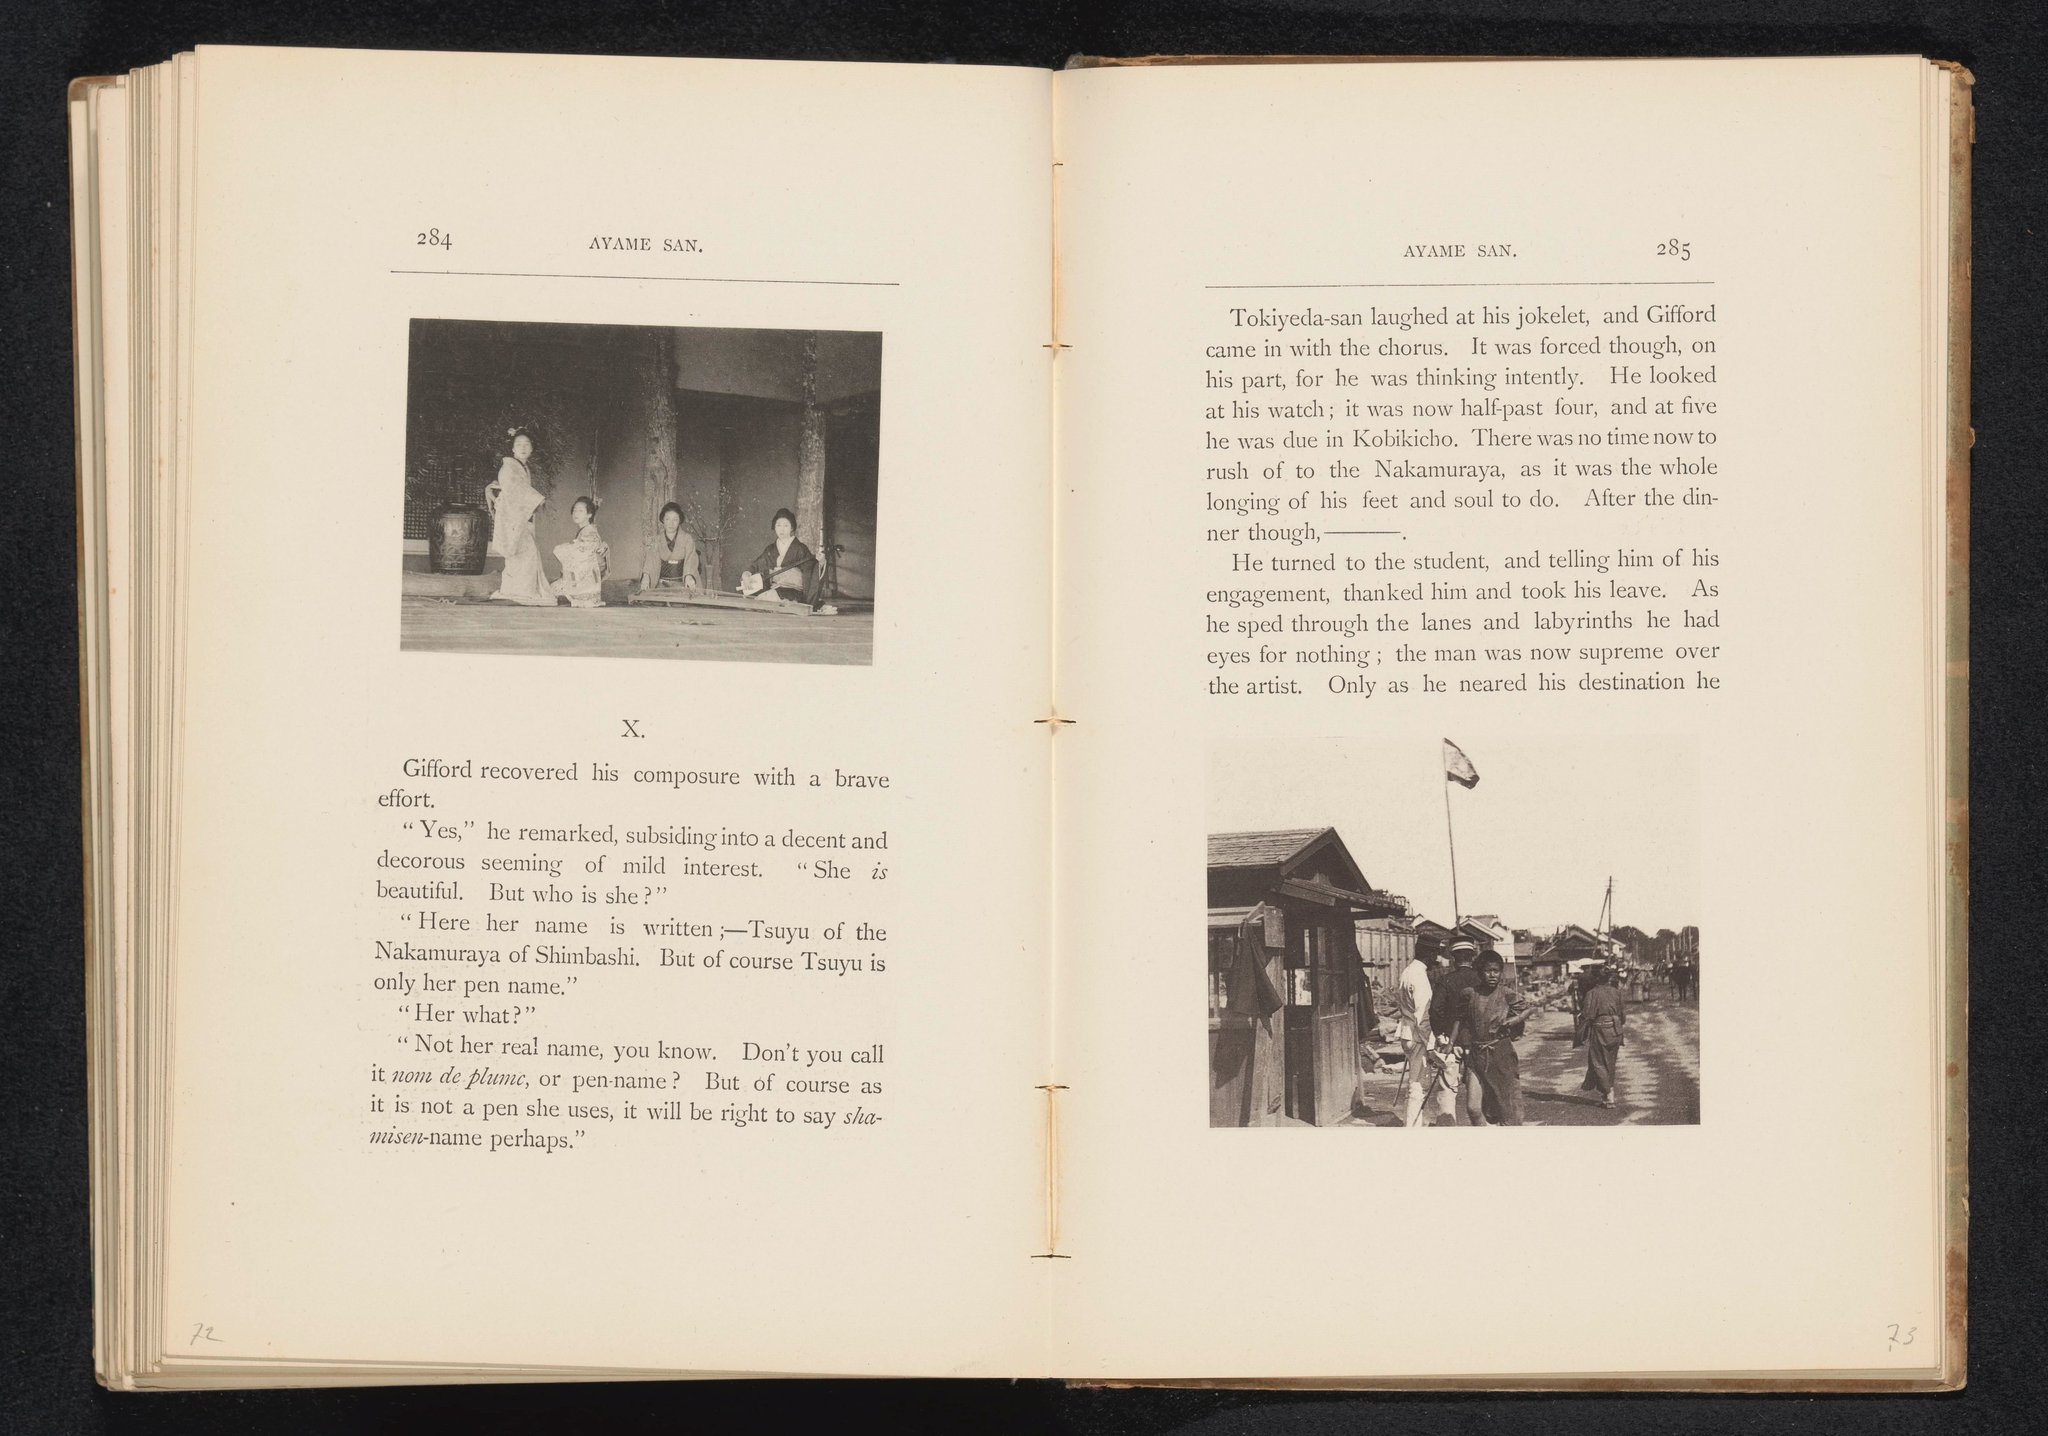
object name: page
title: Vier vrouwen met snaarinstrumenten in een interieur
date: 1882-1892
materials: paper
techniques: photograph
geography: japan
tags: adult woman, string instruments (plucked), interior ~ representation of a building